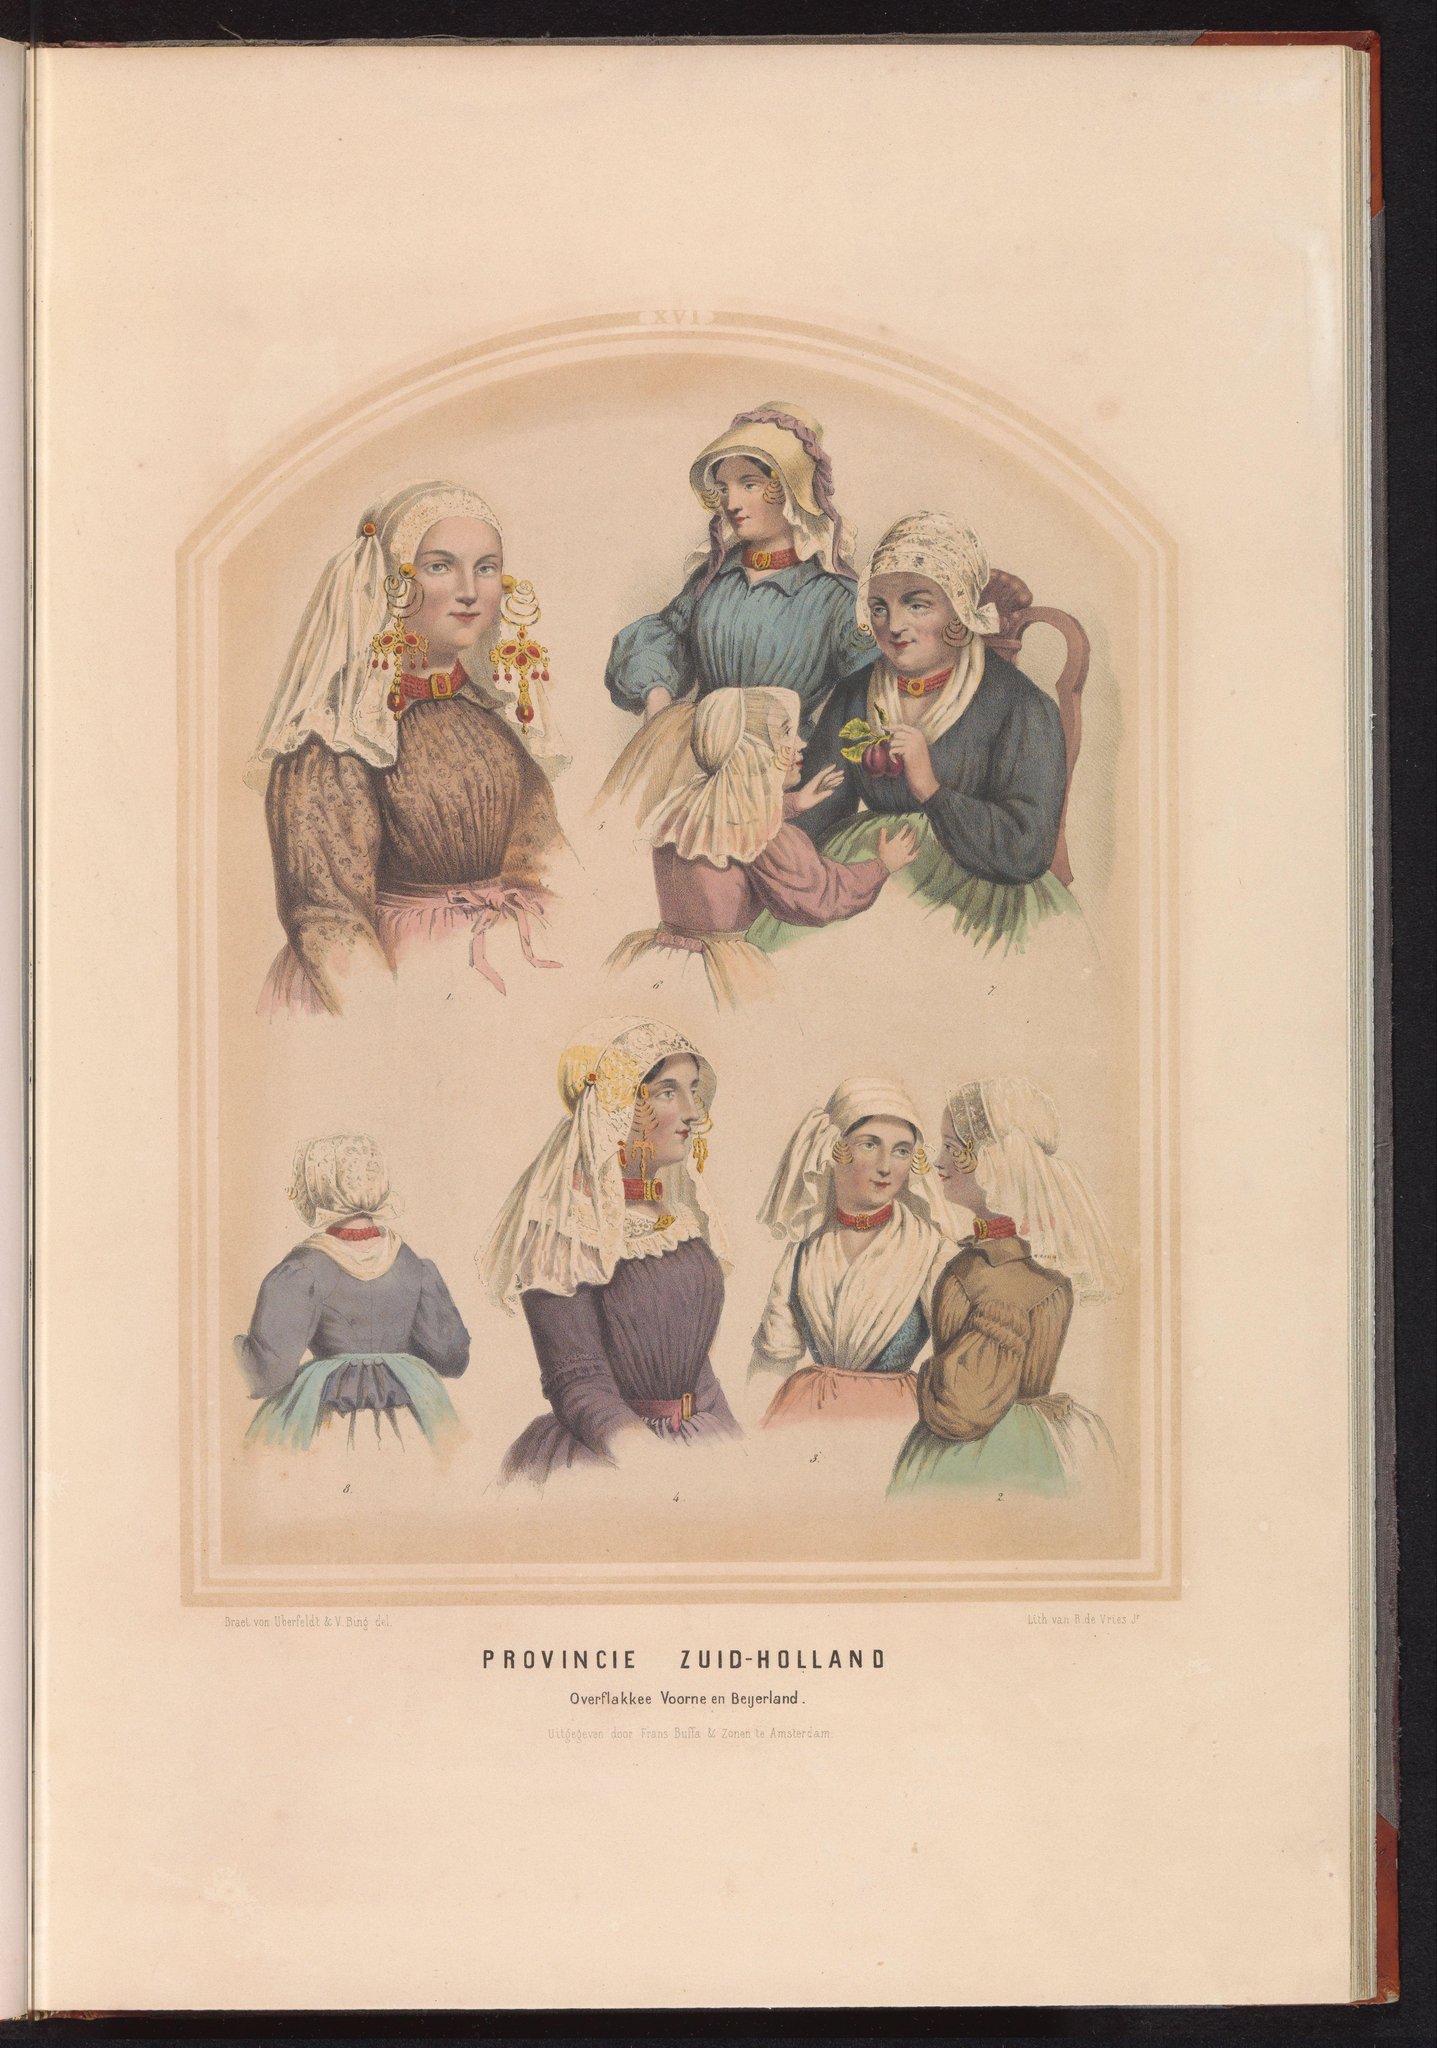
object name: costume print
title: Klederdracht van Overflakkee, Voorne en Oud-Beijerland in Zuid-Holland, 1857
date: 1857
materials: paper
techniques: hand coloring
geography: netherlands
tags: folk costume, regional costume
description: Klederdracht van Overflakkee, Voorne en Oud-Beijerland in de provincie Zuid-Holland. Verschillende studies van vrouwen en meisjes. Illustratie in een boek uit 1857 met 56 platen van Nederlandse klederdrachten.